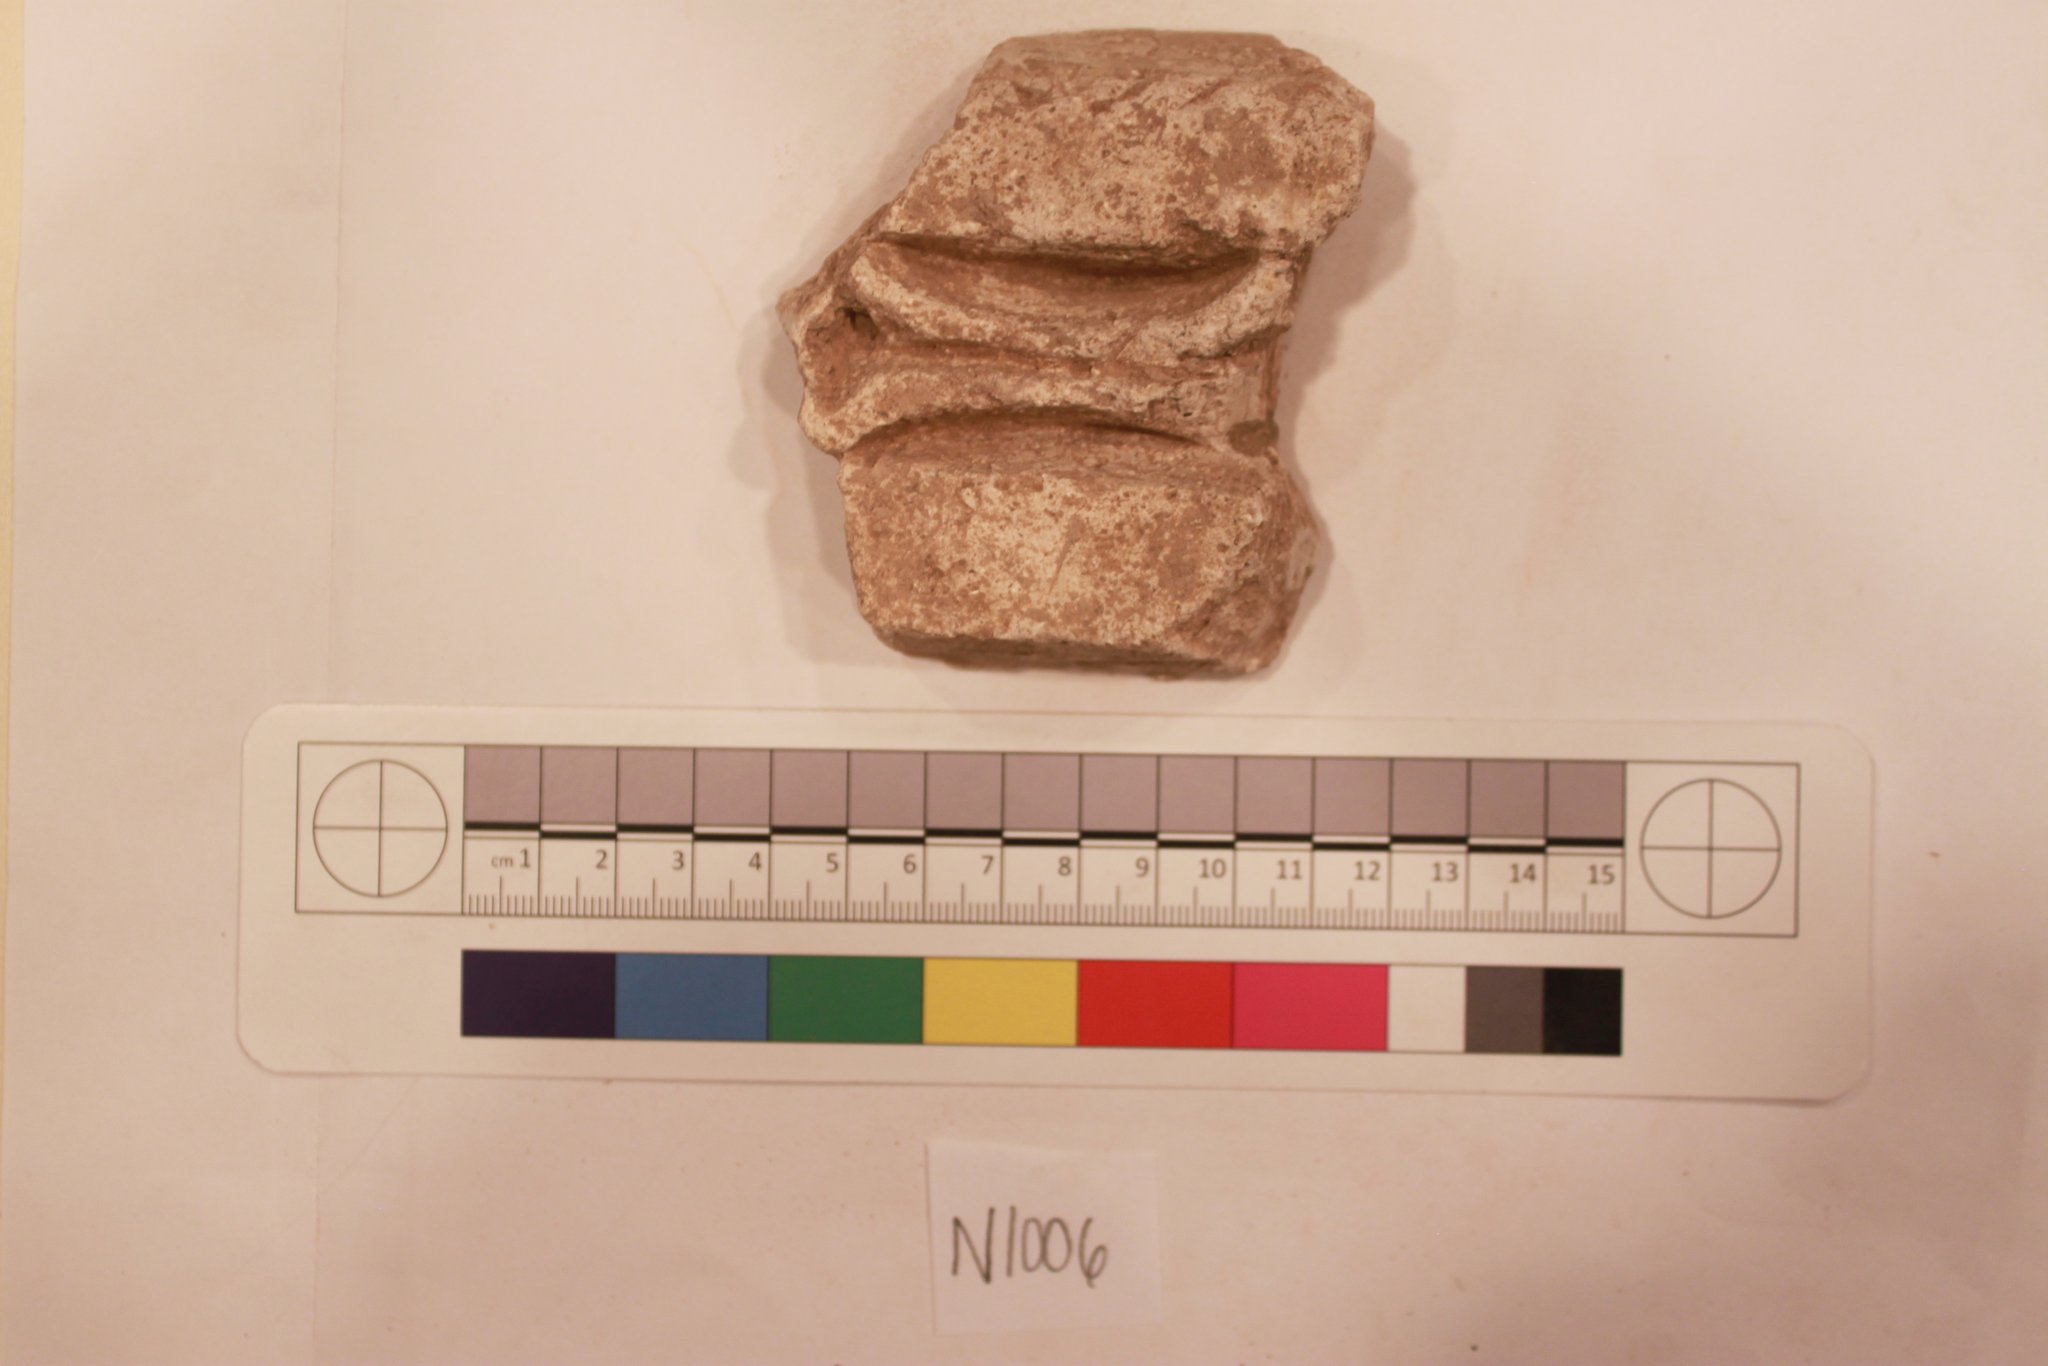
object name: fragment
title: Stucco Fragment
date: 701-1200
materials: plaster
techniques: carving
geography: iran